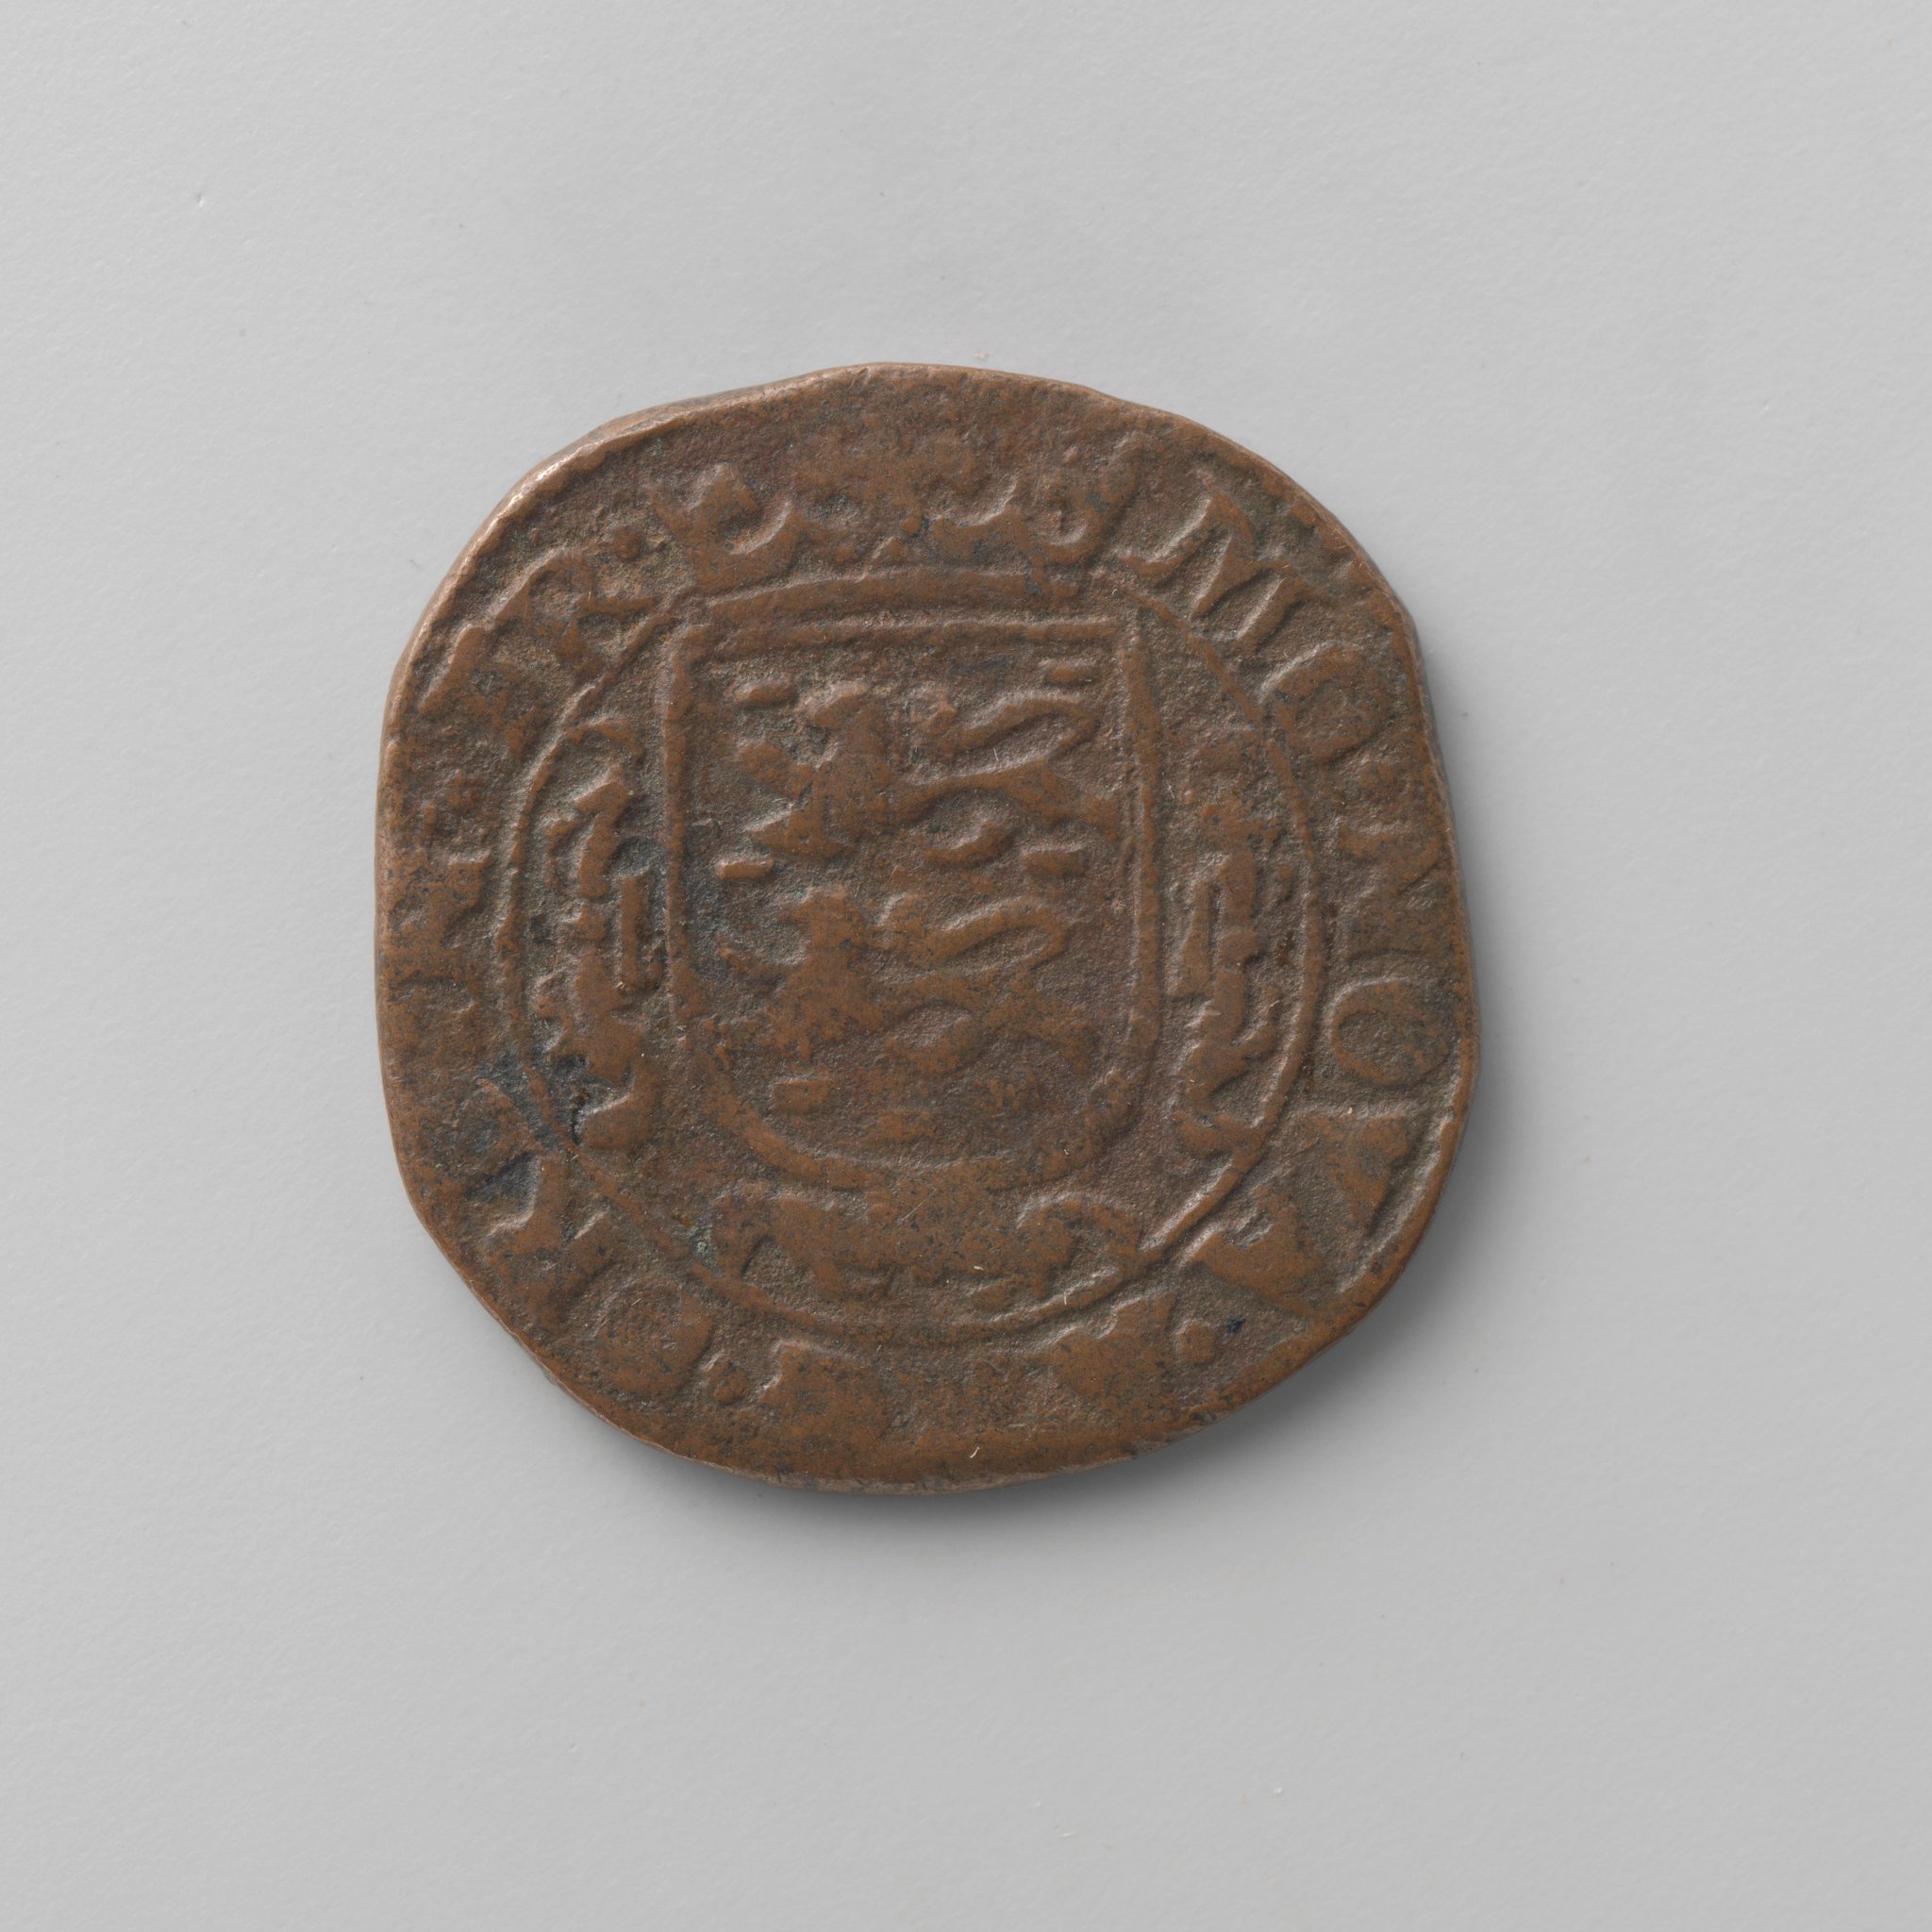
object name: coin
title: Oord van Friesland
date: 1617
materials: copper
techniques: striking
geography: leeuwarden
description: Koperen munt. Voorzijde: tussen waarde-aanduiding F O edelman met muts naar rechts. In rechterhand zwaard. Keerzijde: op kort gebloemd kruis gekroond wapenschild van Friesland.